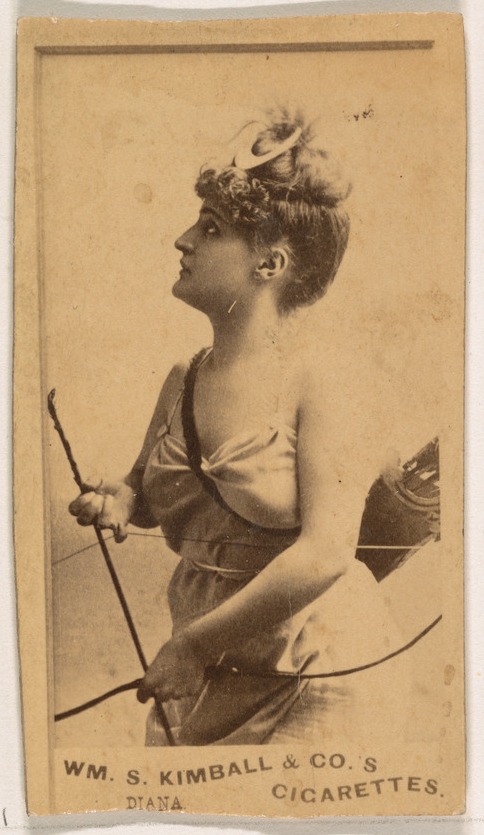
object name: photograph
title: Diana, from the Actresses series (N203) issued by Wm. S. Kimball & Co.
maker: william s. kimball & company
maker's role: publisher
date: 1889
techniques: color lithograph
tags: profiles,women,actresses